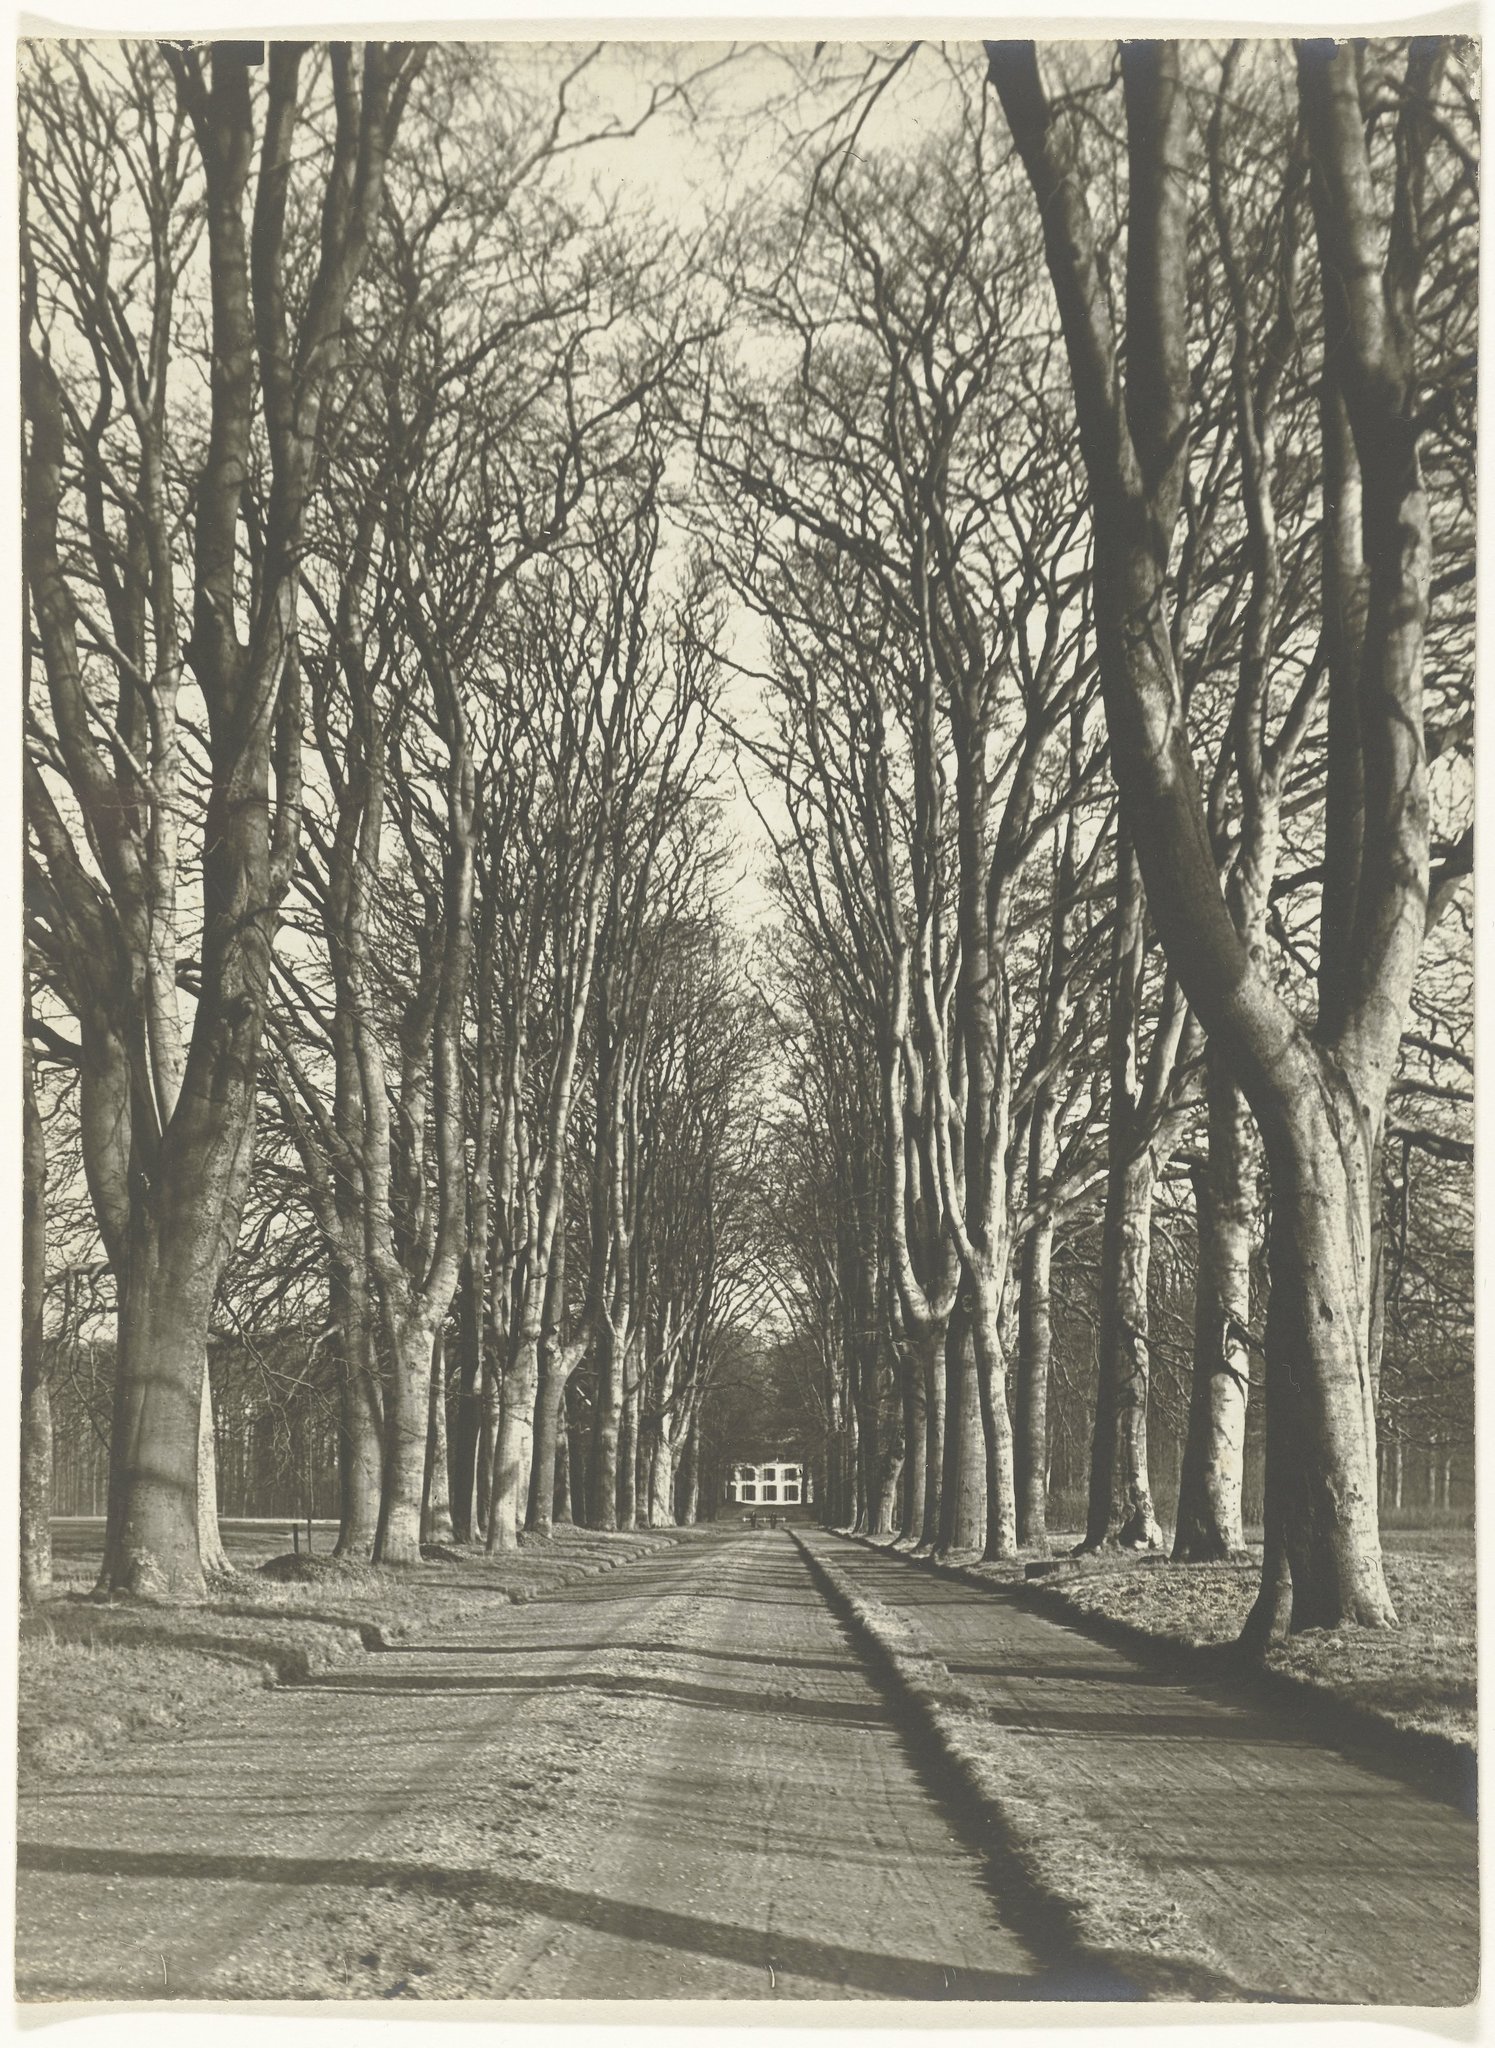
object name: photograph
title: Beukenlaan in Voorst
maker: richard tepe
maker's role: fotograaf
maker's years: 1864-1952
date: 1900-1930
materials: photographic support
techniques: gelatin silver print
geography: netherlands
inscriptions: annotation: ‘Groote Beukenlaan / genaamd Poll-laan / in het vroege voorjaar / te Voorst (Gld)’, signature: ‘foto / R Tepe’